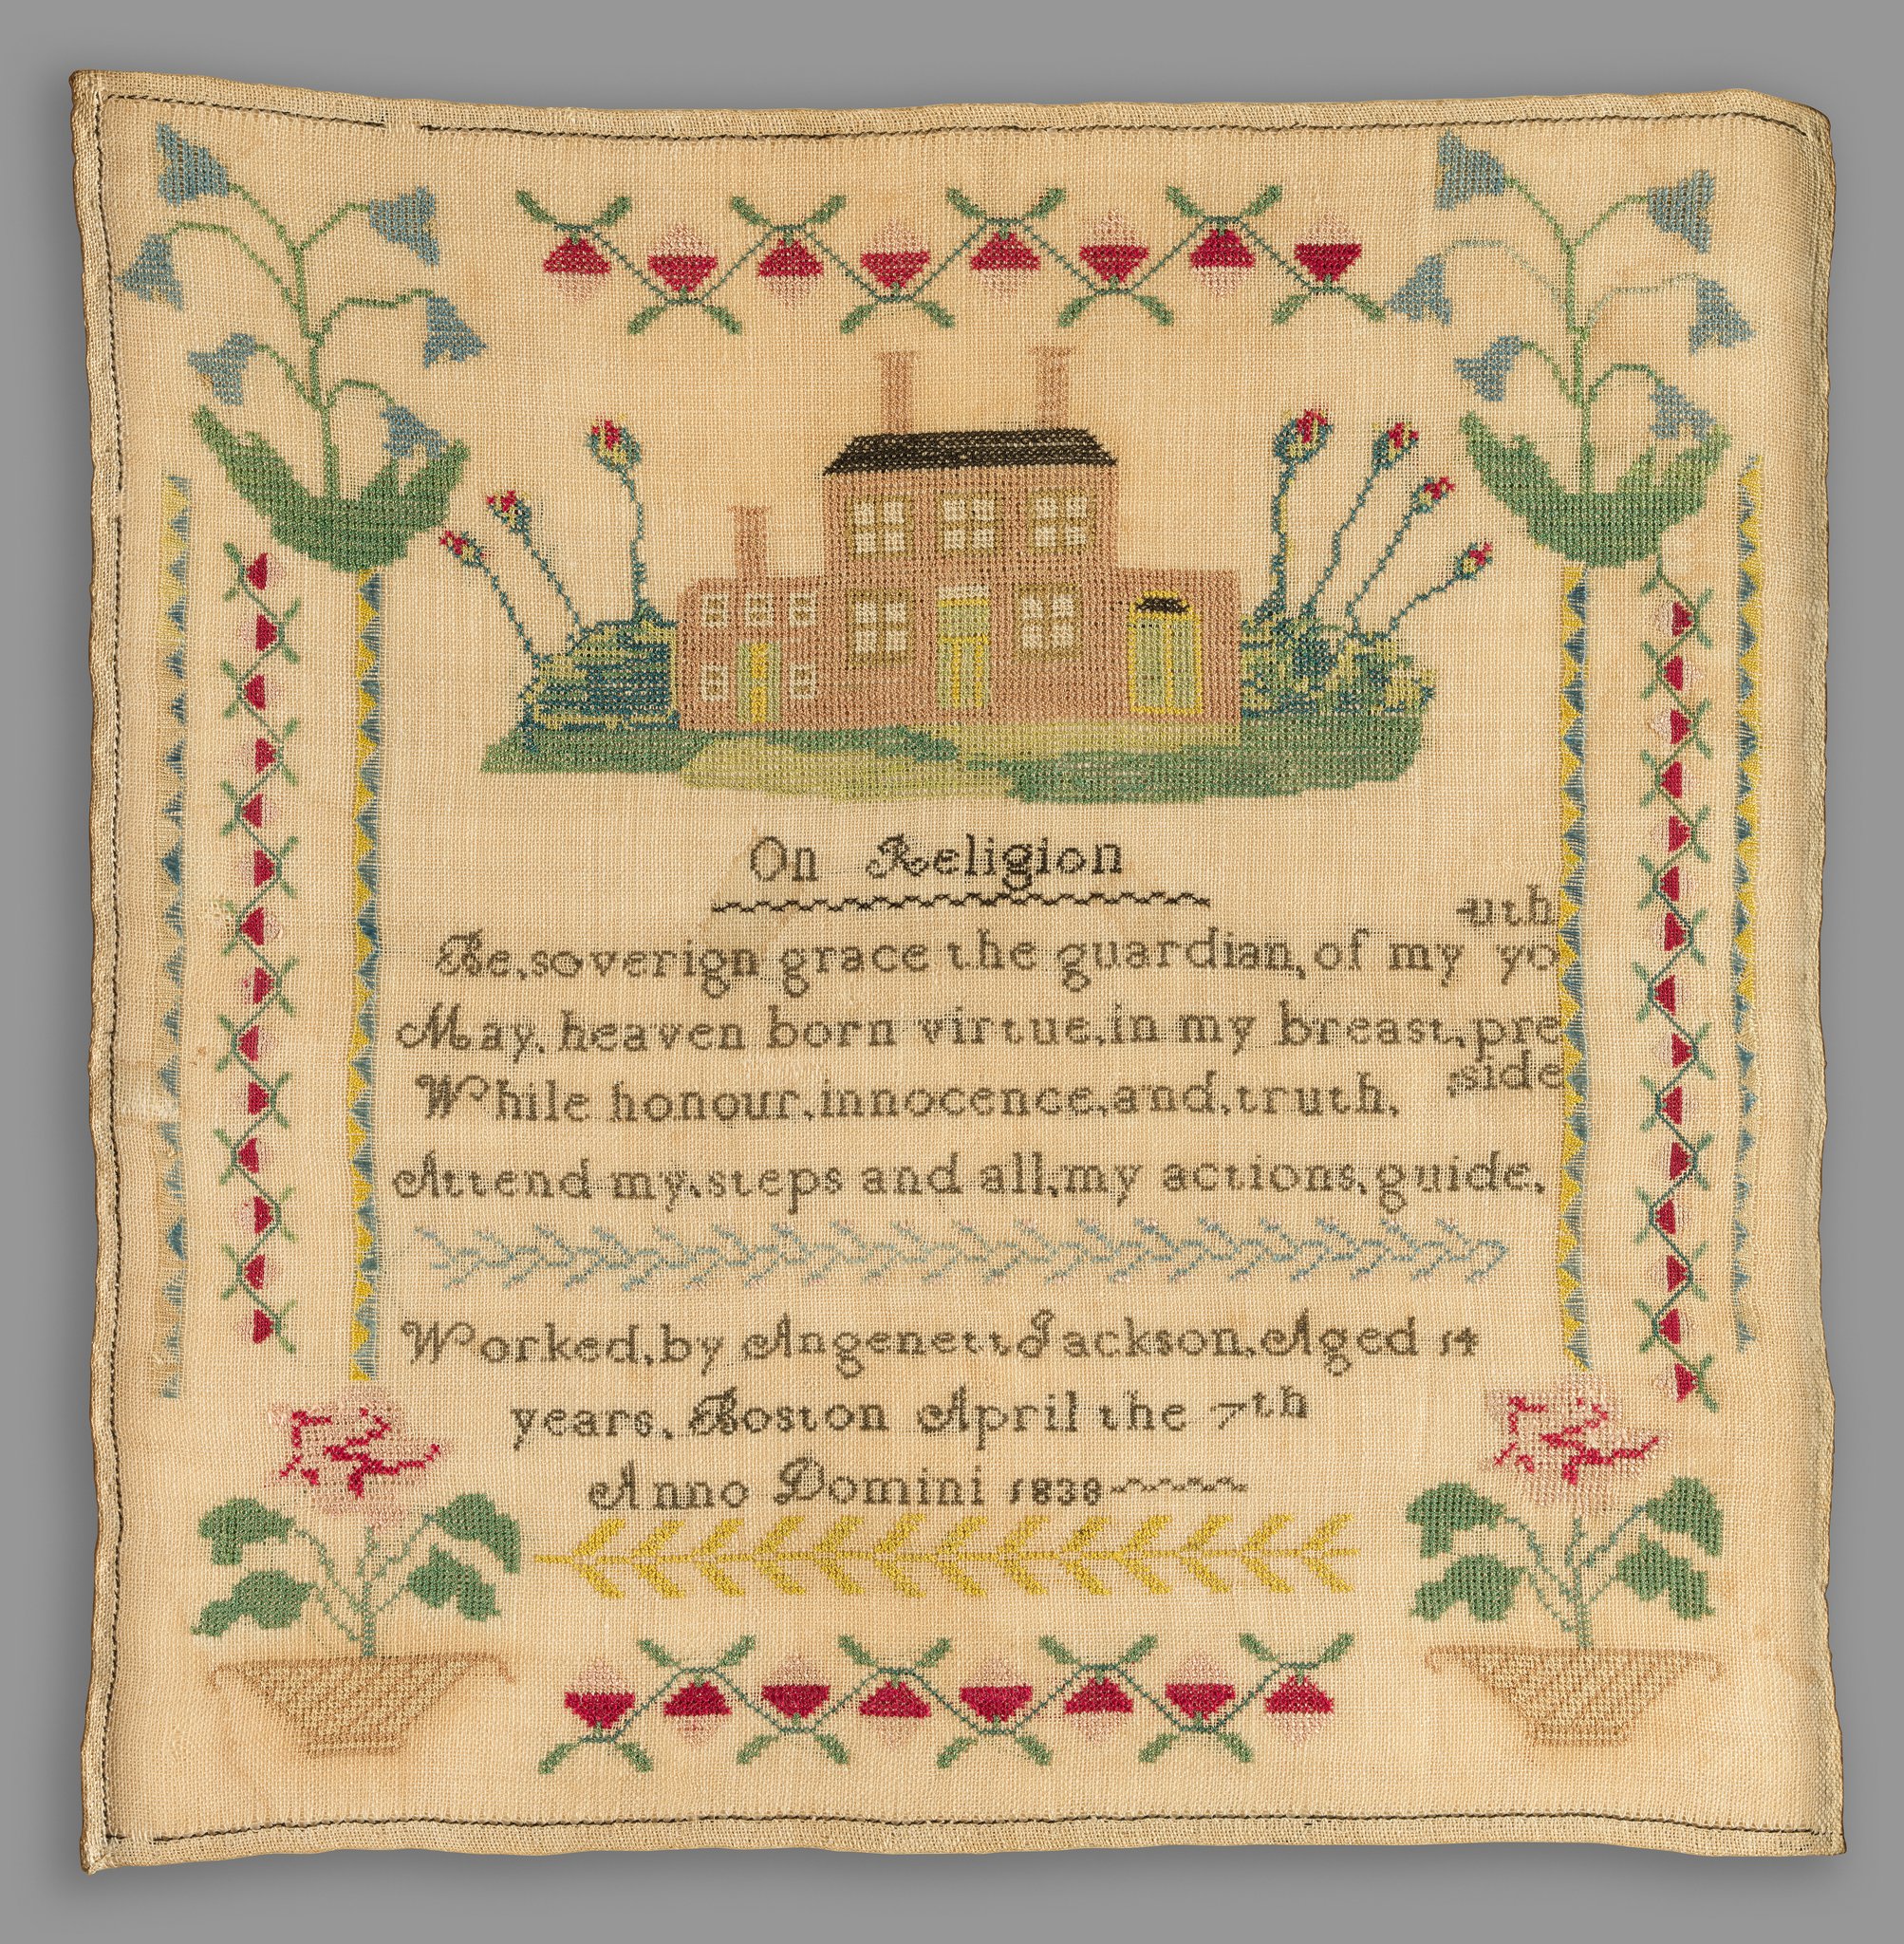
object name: sampler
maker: angenett jackson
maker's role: maker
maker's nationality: american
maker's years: 1823-1903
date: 1838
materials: linen, silk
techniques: embroidery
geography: united states